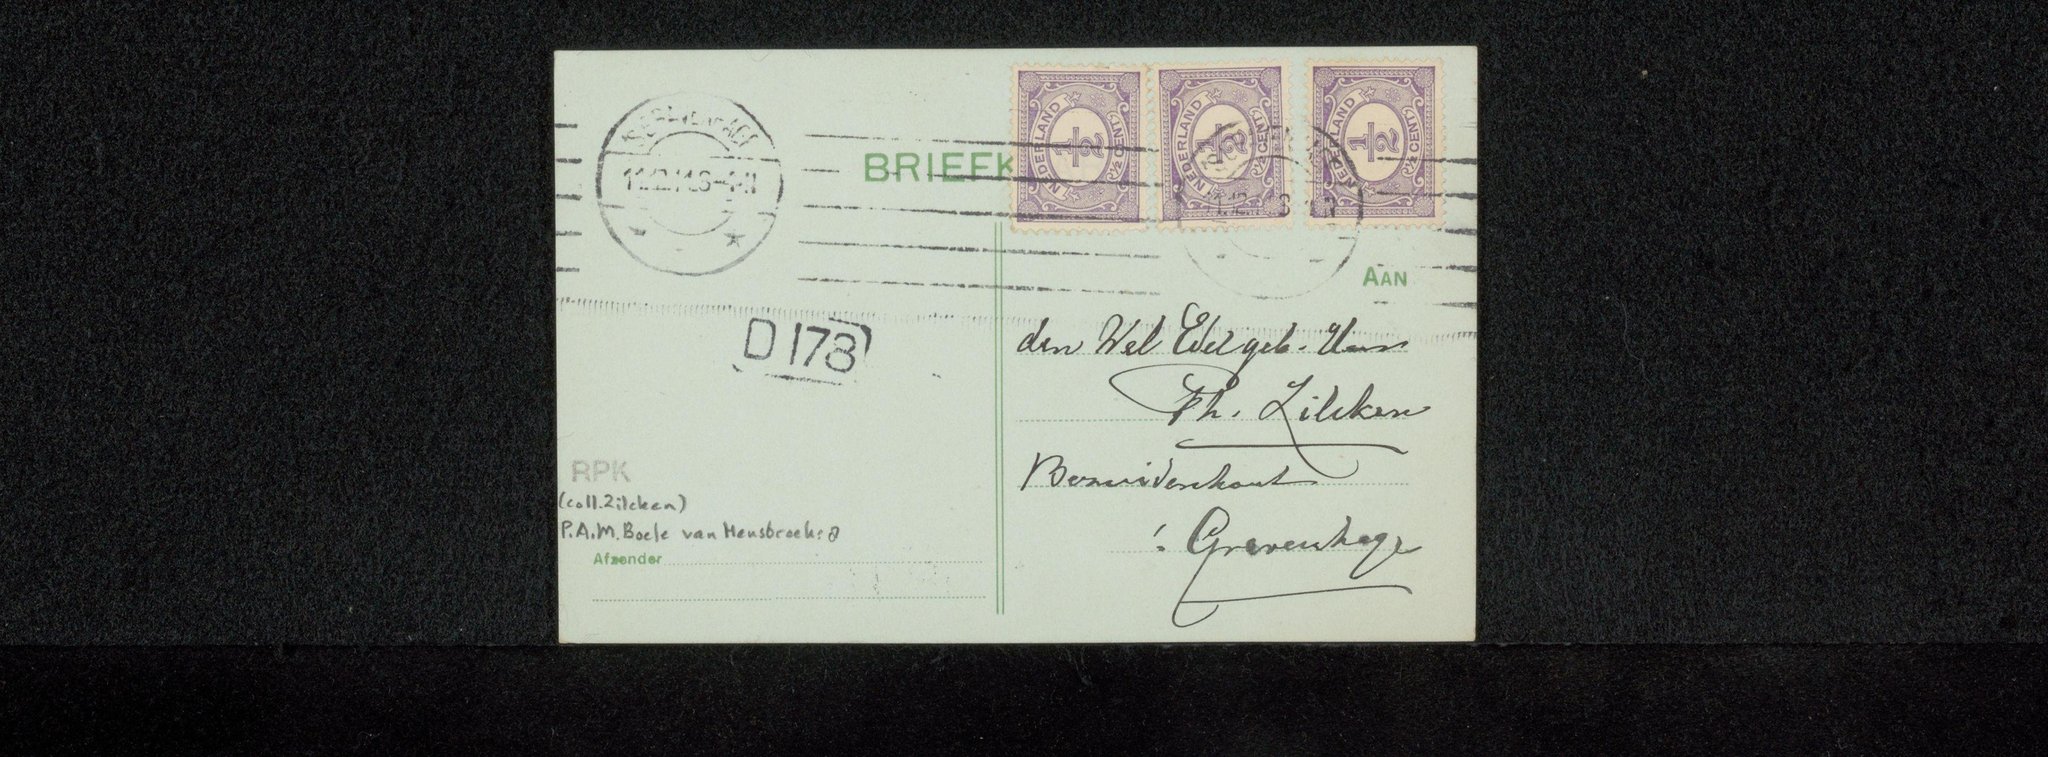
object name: postcard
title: Briefkaart aan Philip Zilcken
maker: pieter andreas martin boele van hensbroek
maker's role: publisher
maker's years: 1853-1912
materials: cardboard, ink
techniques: pen, writing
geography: the hague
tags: painter, draughtsman, philip zilcken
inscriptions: collector's mark: ‘RPK’